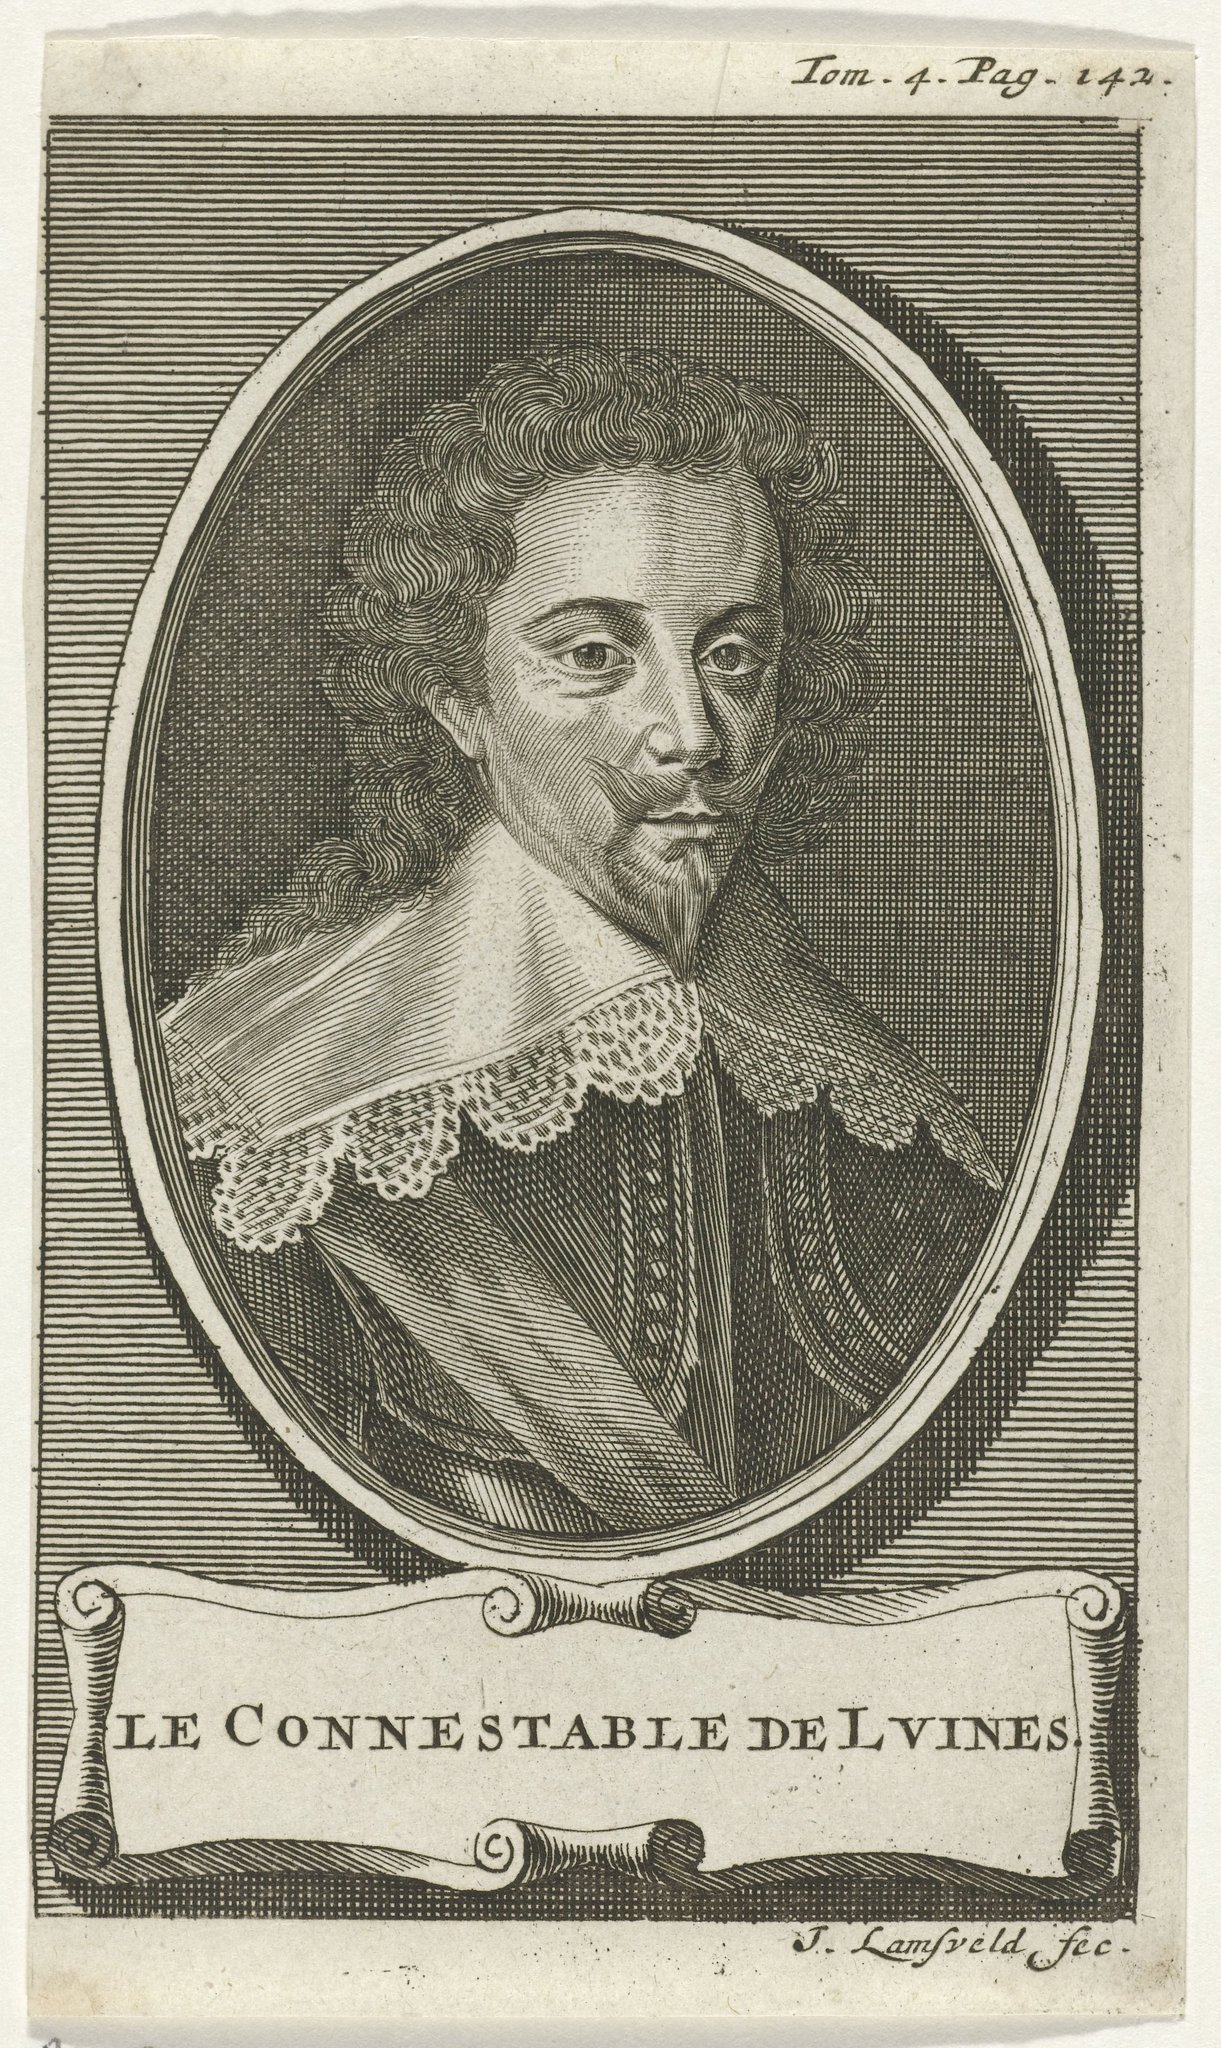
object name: book illustration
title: Portret van de grootofficier van Luynes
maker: jan lamsvelt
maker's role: print maker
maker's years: 1674-1743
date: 1684-1743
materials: paper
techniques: engraving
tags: policeman, constable, anonymous historical person portrayed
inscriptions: collector's mark: Lugt 2228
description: Portretbuste in ovaal naar rechts van een anonieme grootofficier van Luynes, blootshoofds en gehuld in een harnas. Onder het ovaal staat de titel van de geportretteerde. Prent rechtsboven gemerkt: Tome 4. pag. 142.